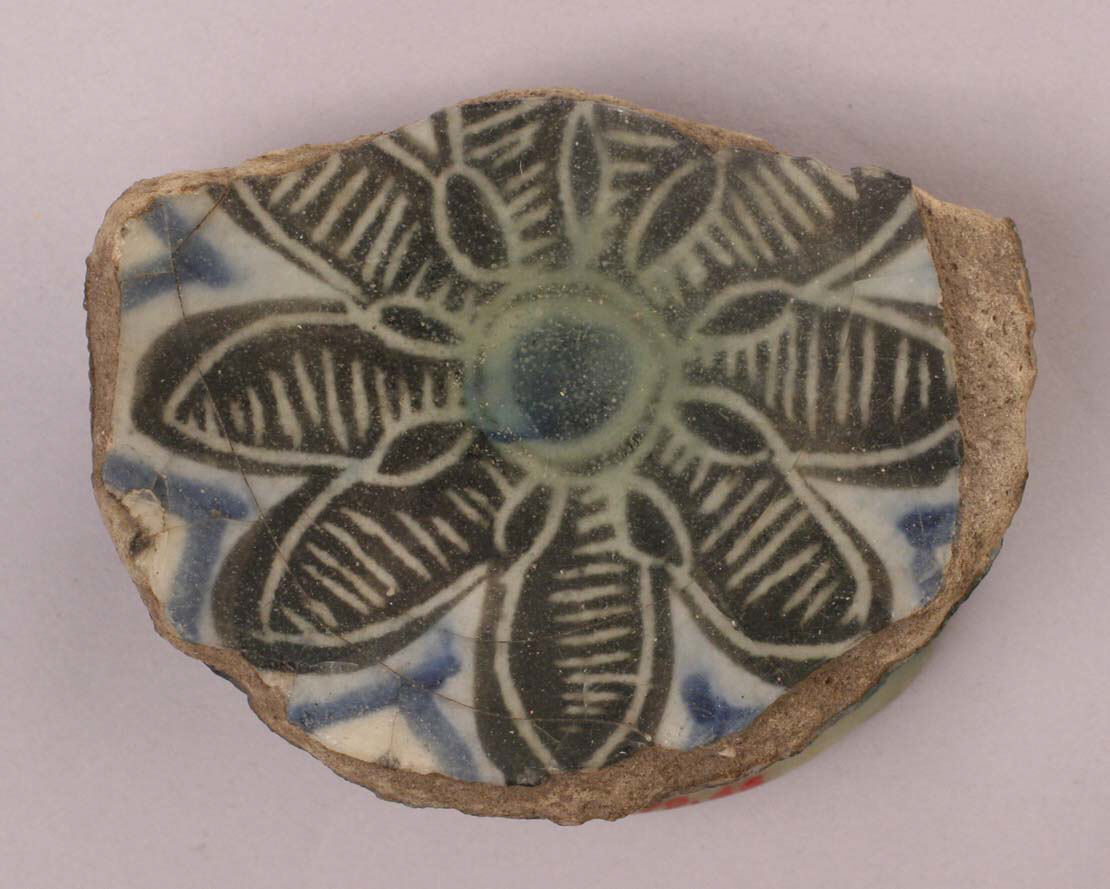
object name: fragment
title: Ceramic Fragment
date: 1201-1600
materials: glaze, stonepaste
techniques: painting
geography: egypt